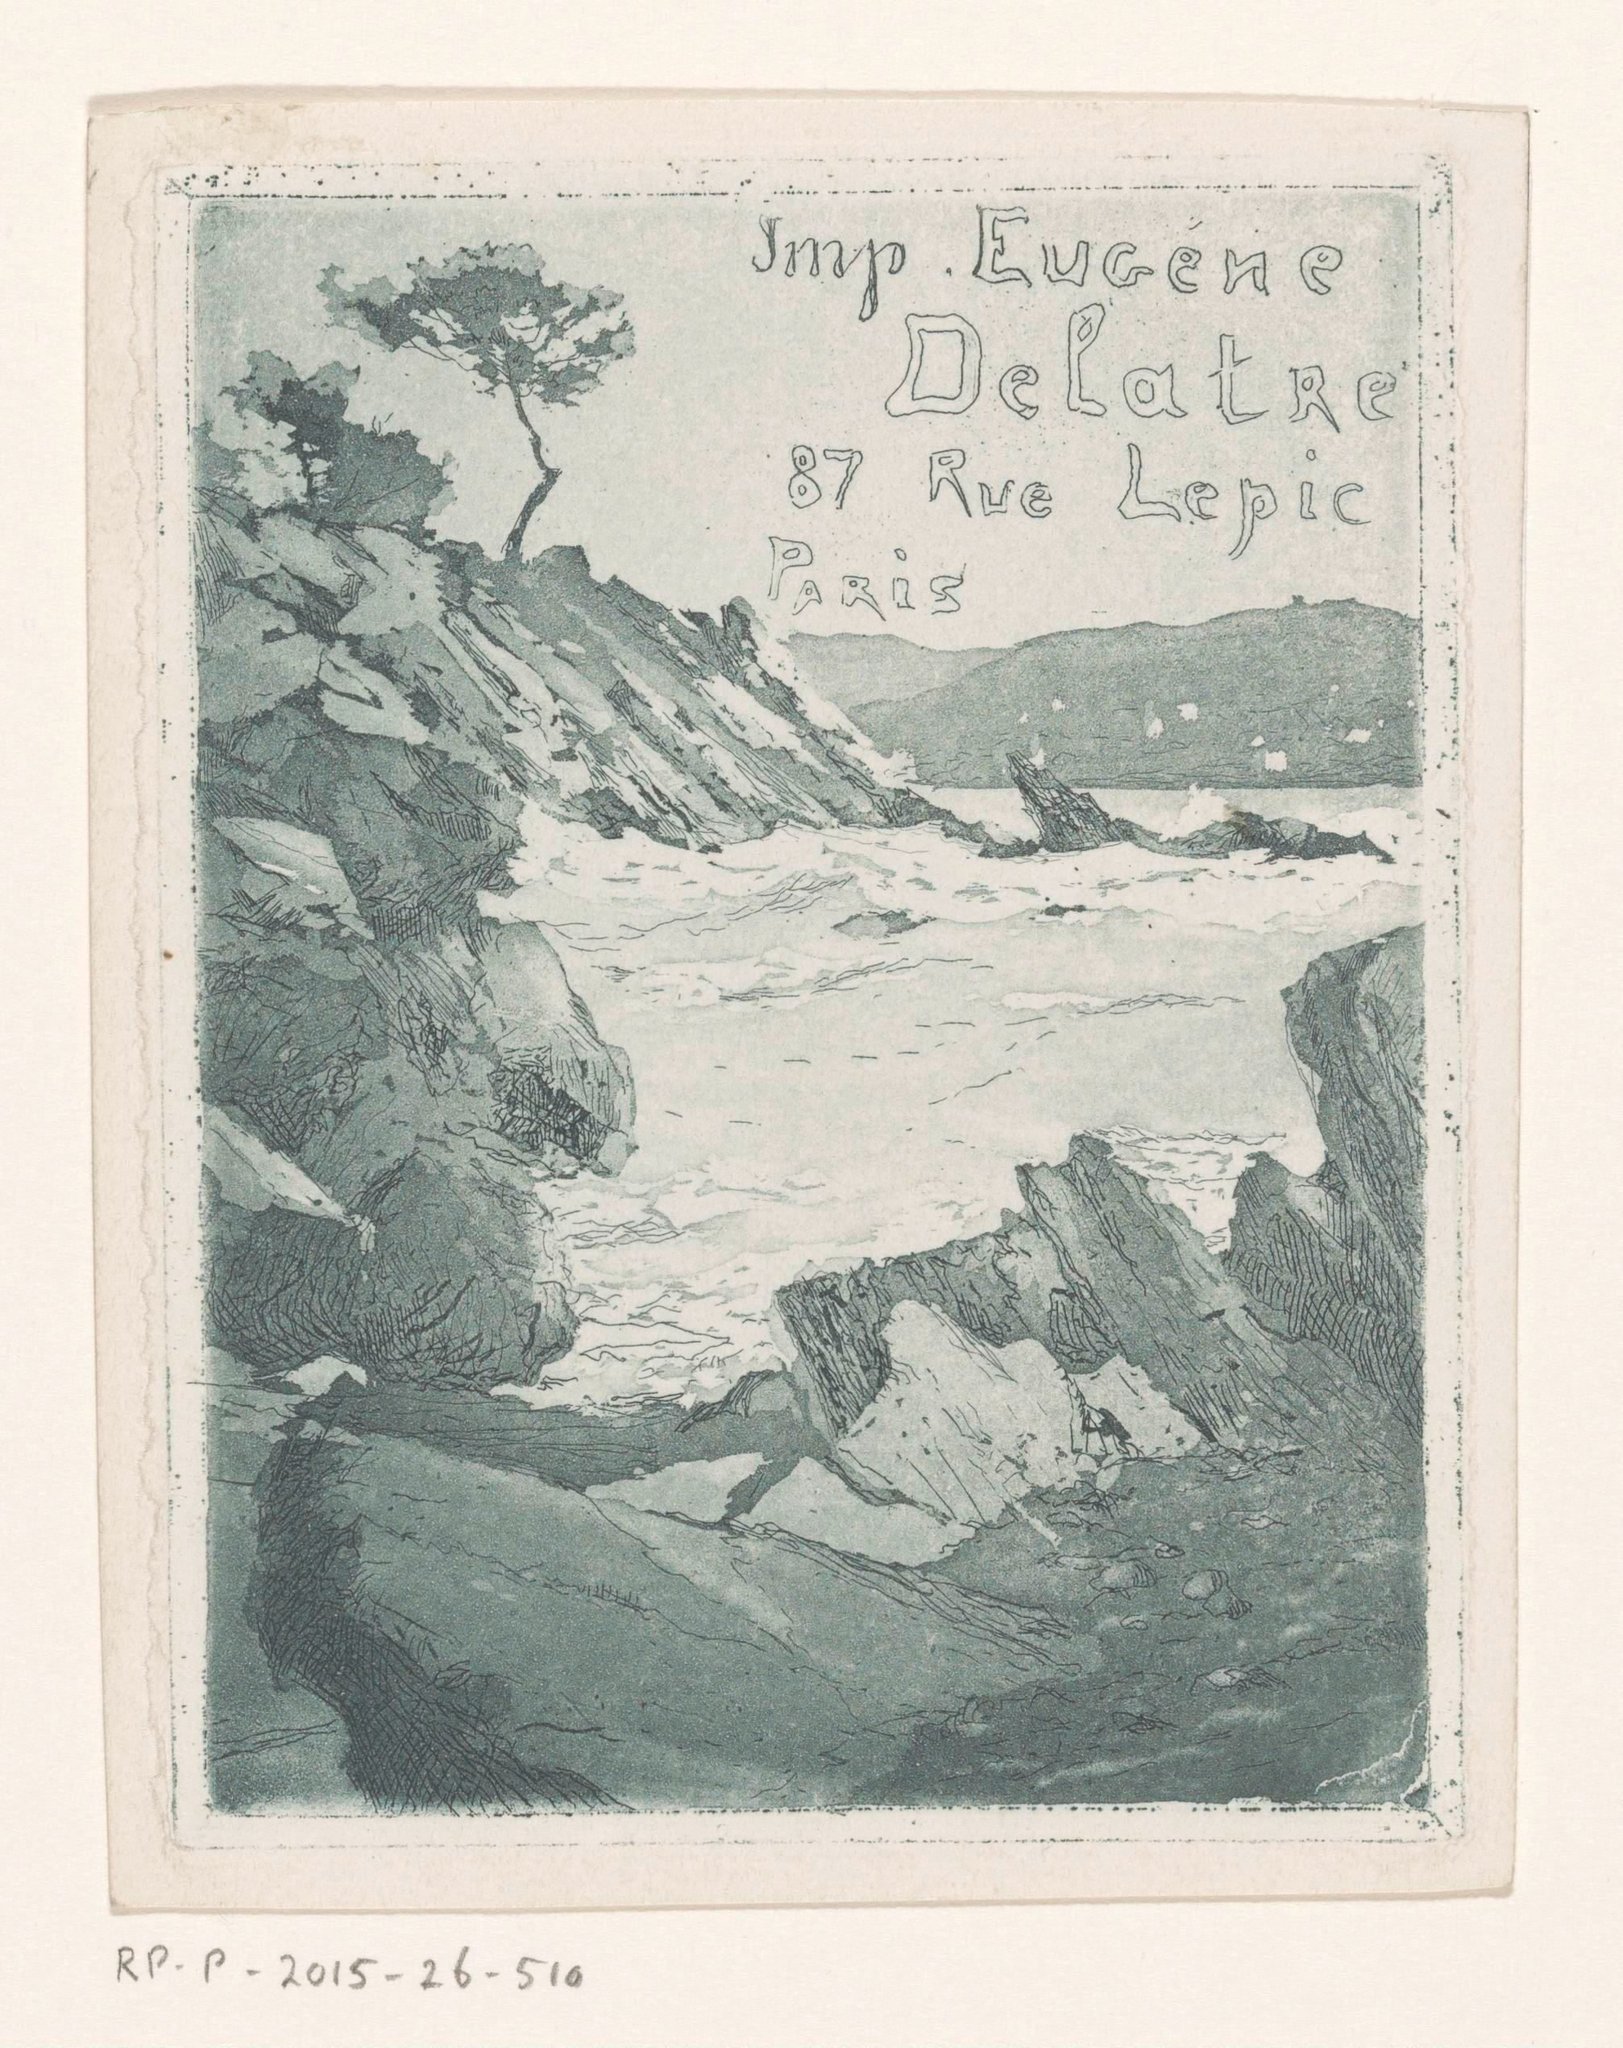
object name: print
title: Visitekaartje van drukker Eugène Delâtre te Parijs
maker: eugène delâtre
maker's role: print maker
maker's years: 1864-1938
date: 1907-1938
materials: paper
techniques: aquatint, etching, intaglio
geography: paris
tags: coast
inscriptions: collector's mark: Lugt 4779, collector's mark: Lugt 2228